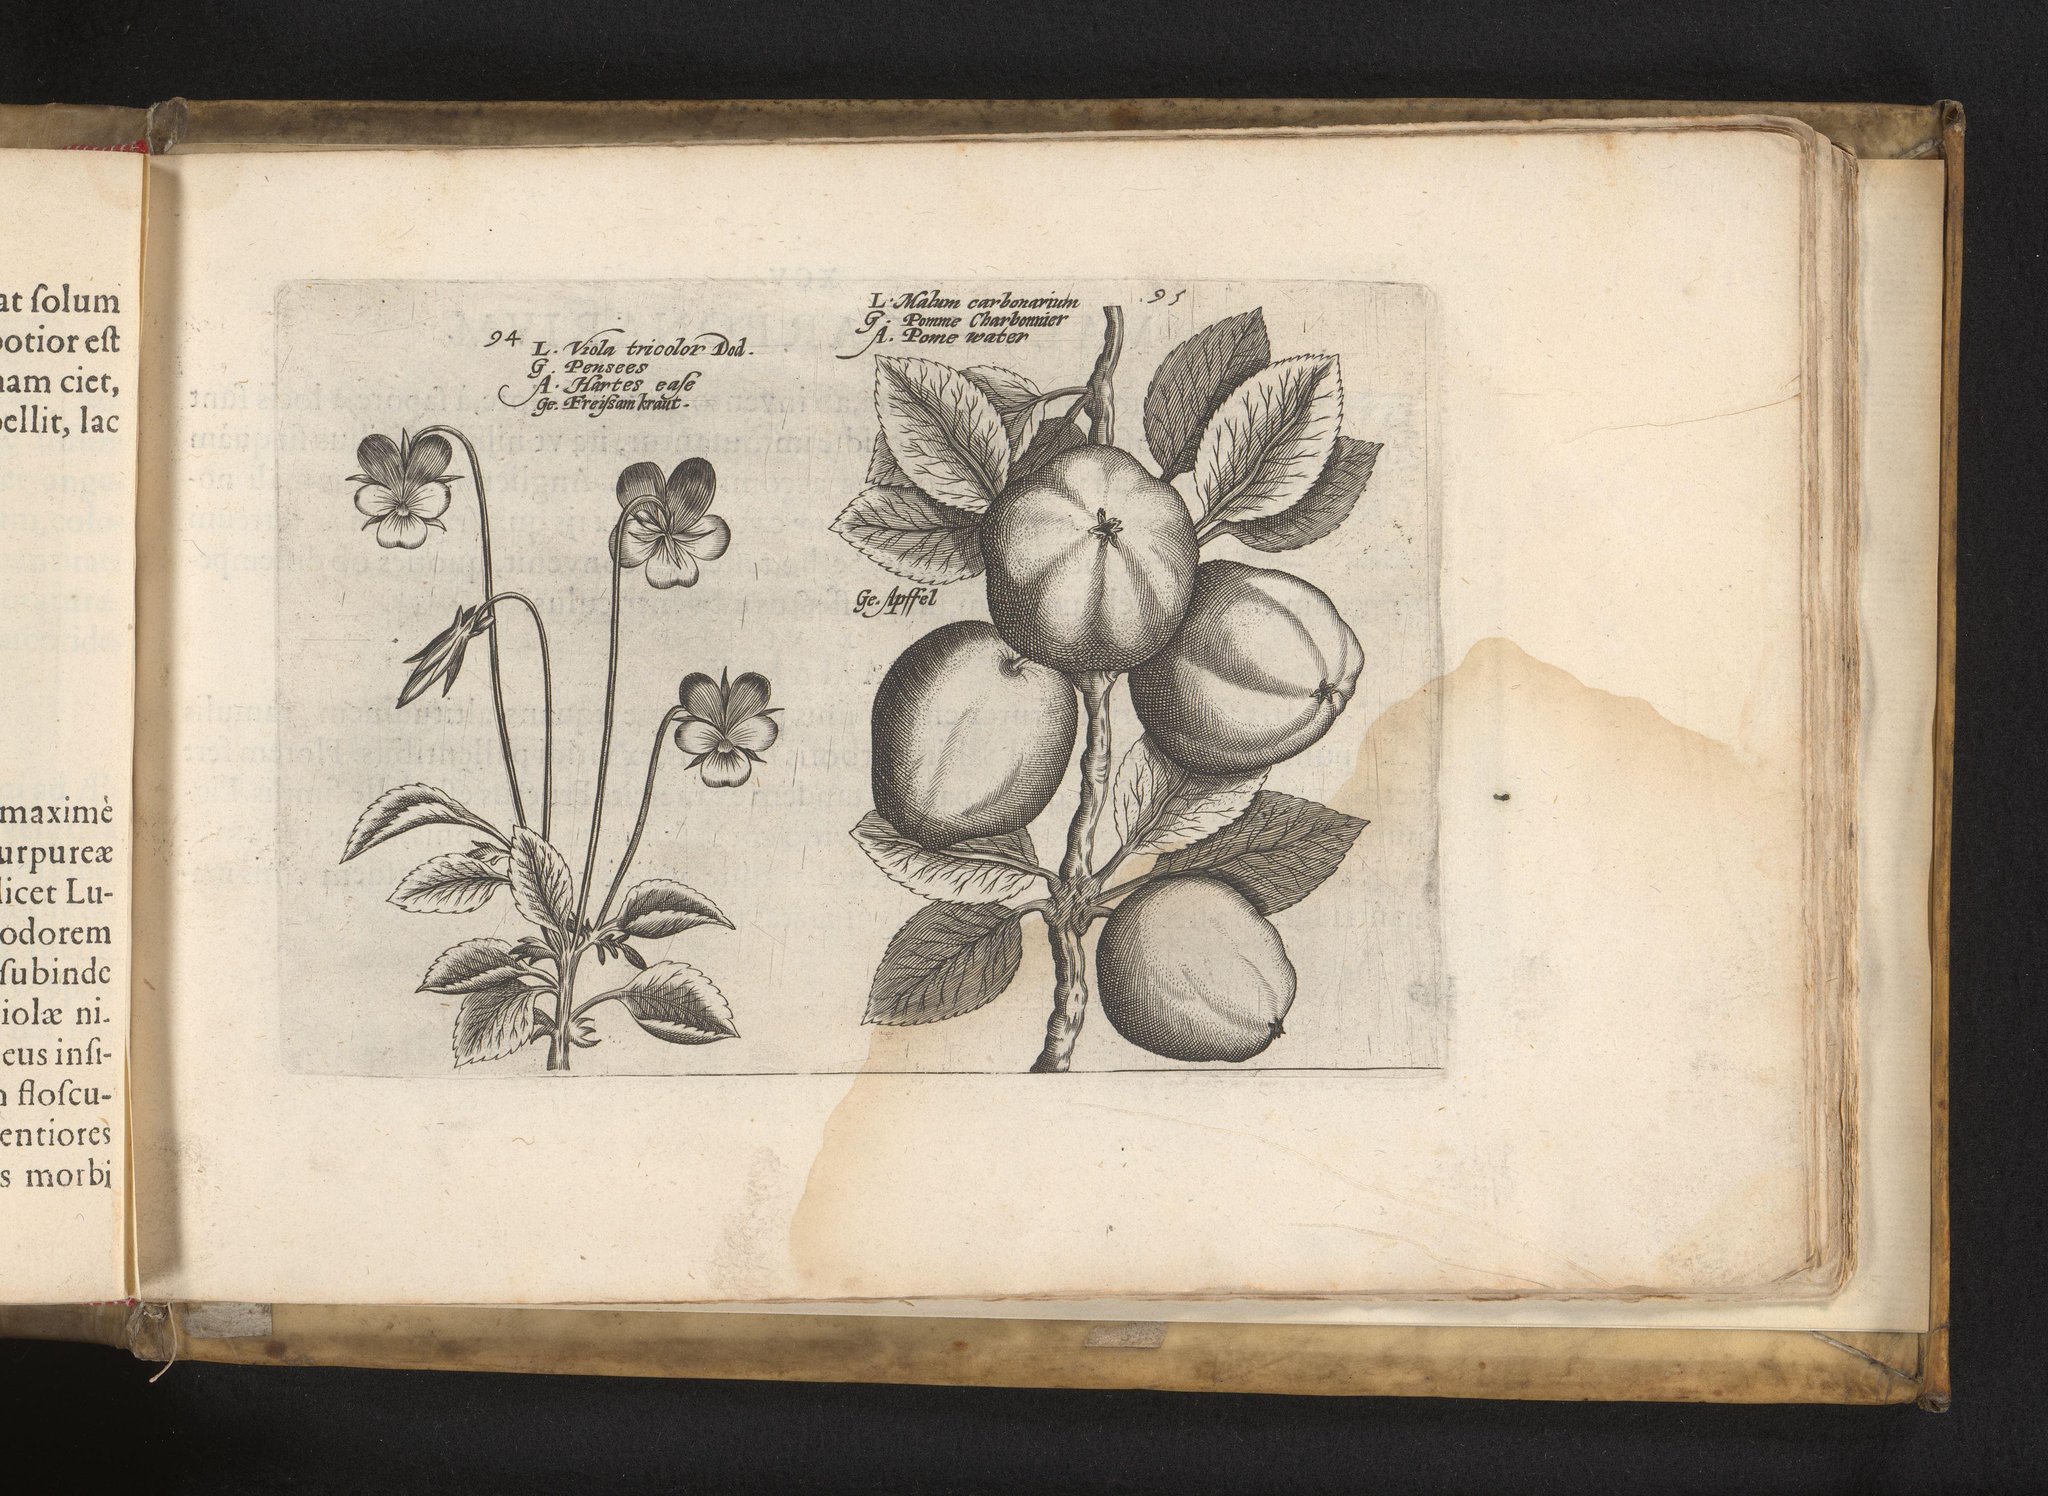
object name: print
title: Driekleurig viooltje en appel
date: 1617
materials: paper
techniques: engraving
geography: arnhem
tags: flowers, fruits: apple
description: Prent uit: Passe, Crispijn van de (II). Hortus floridus in quo rariorum & minus vulgarium florum icones ad vivam veramque formam. Arnhem: Johannes Janssonius, 1617.